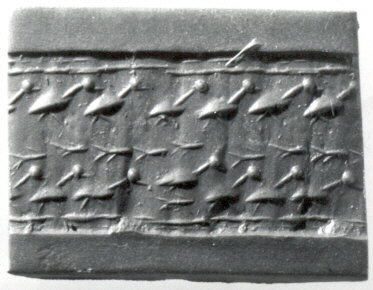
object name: cylinder seal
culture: mitanni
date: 1500-1301 BCE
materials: stone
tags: birds,fish